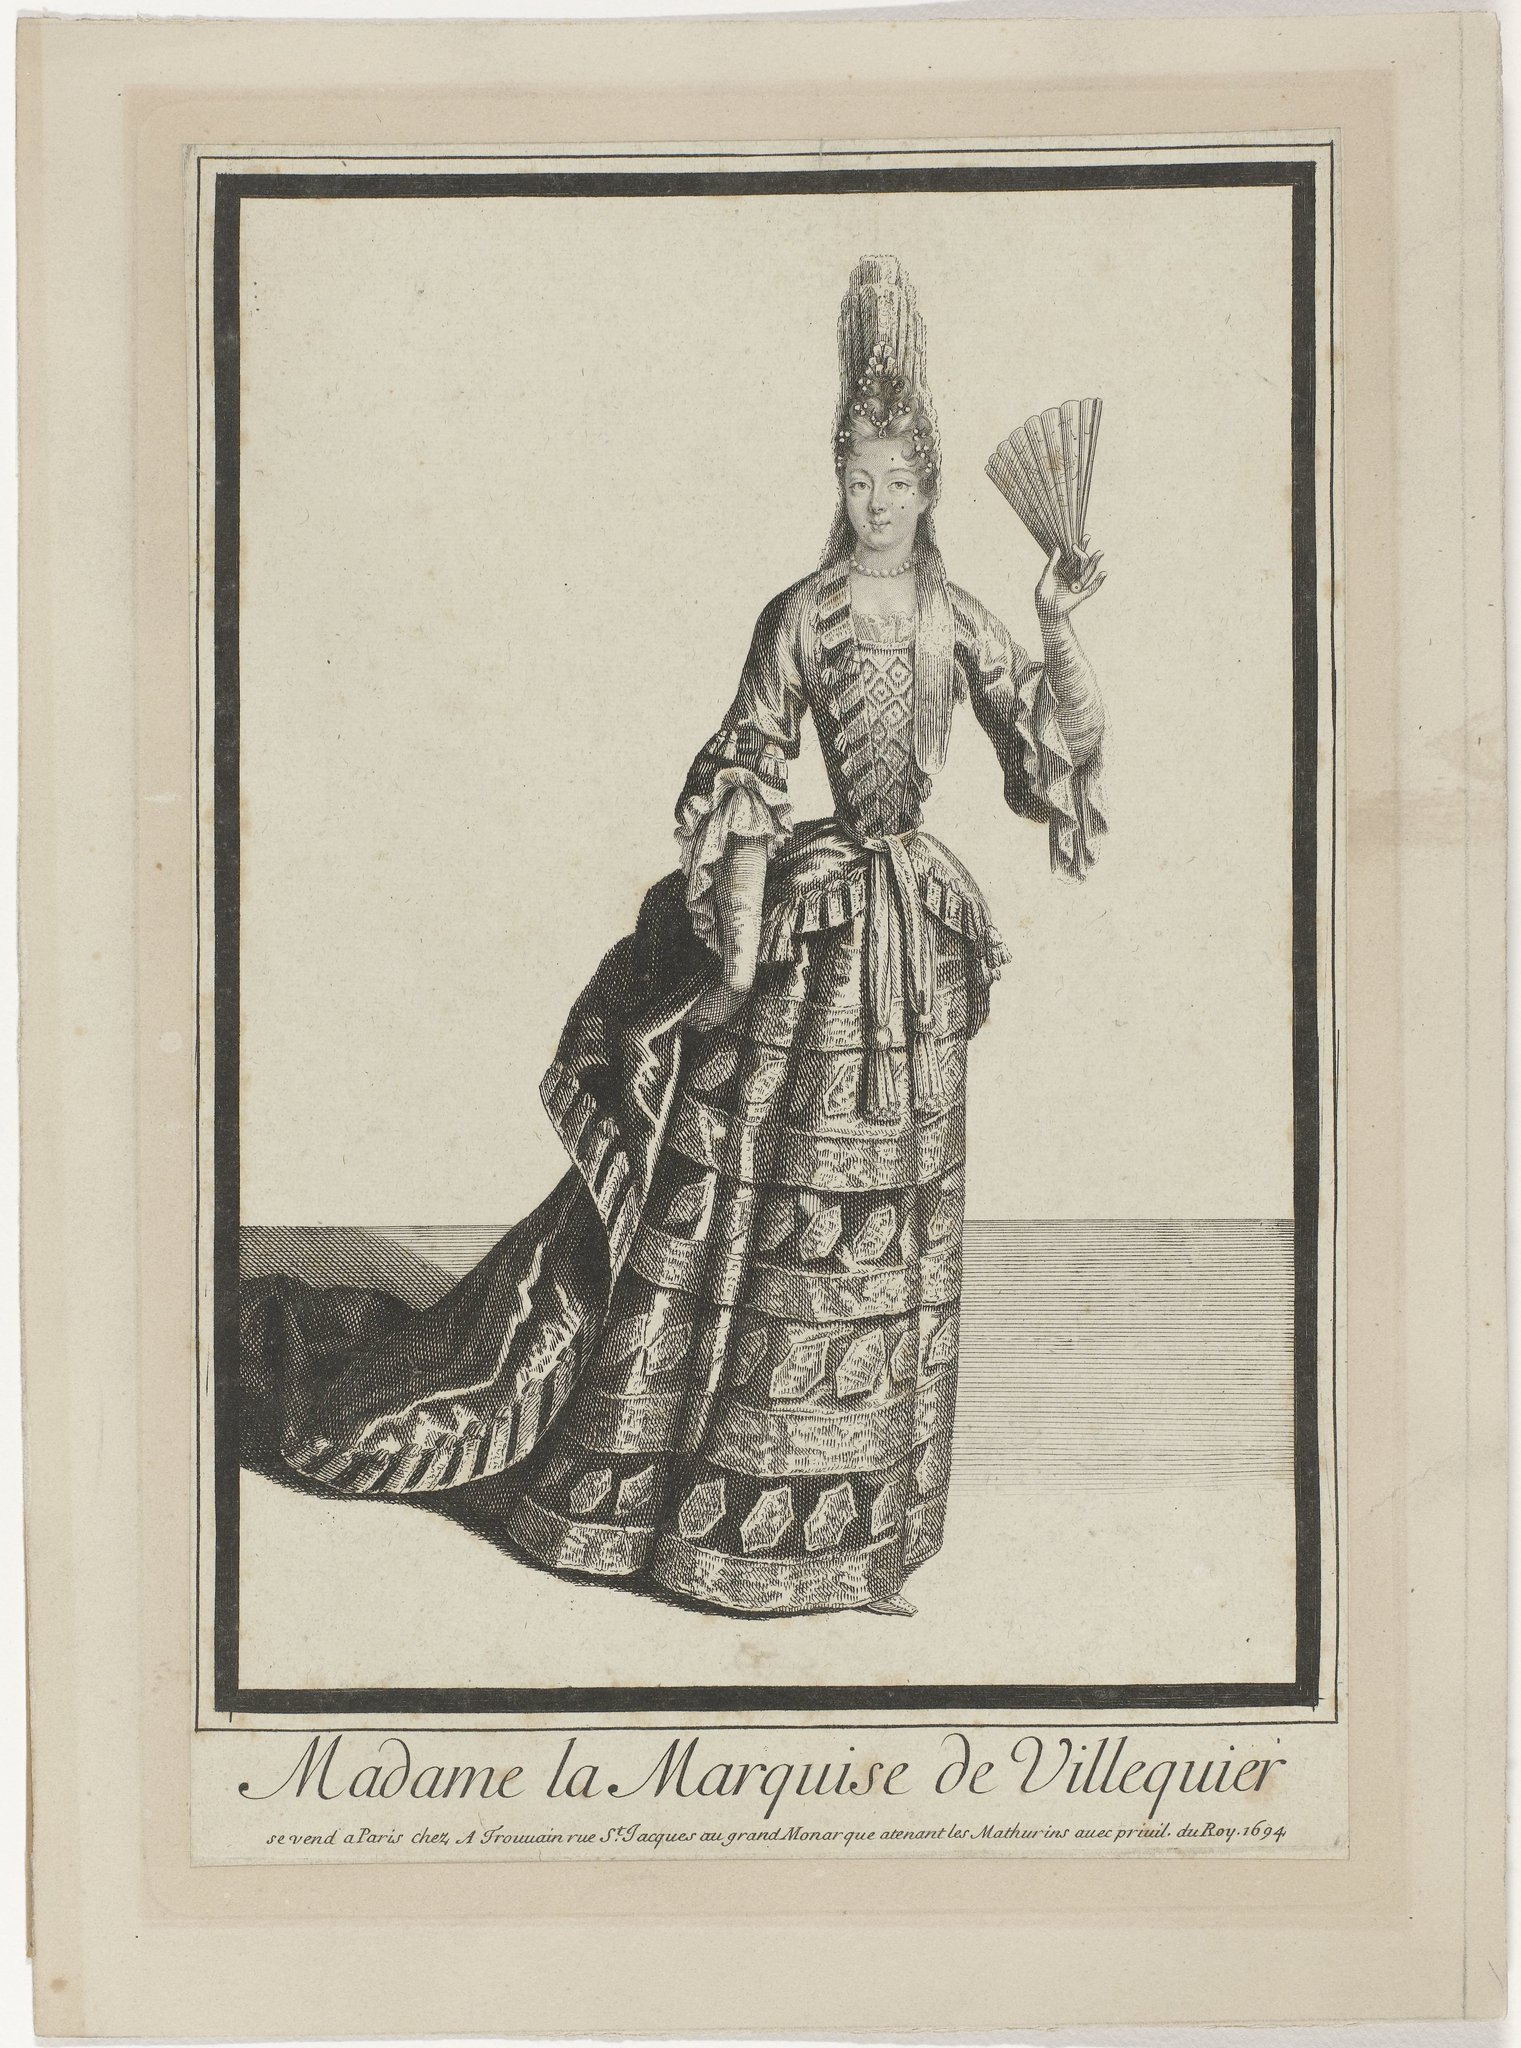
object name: costume print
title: Madame la Marquise de Villequier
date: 1694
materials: paper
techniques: engraving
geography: paris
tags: pendant, trinket, 'breloque' (+ women's clothes), piece of clothing covering the breast or décolleté (stomacher) (+ women's clothes), fashion plates, skirt (+ women's clothes), gloves, mittens, etc. (+ women's clothes), head-gear: fontange (+ women's clothes), dress, gown: manteau (+ women's clothes), pearl; pearl necklace (+ women's clothes)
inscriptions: title: ‘Madame la Marquise de Villequier’, address: ‘se vend a Paris chez A. Trouvain rue St. Jacques au grand Monarque atenant les Mathurins avec privil. du Roy. 1694’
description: Markiezin de Villequier, gekleed in manteau met sleep en kwasten en een rok met falbala's. Op het hoofd een fontange met slippen; vier mouches op het gezicht. Accessoires: een om de taille geknoopte ceintuur, brisé-waaier, engageantes, handschoenen, kralencollier (parelcollier) en sieraden in het haar.